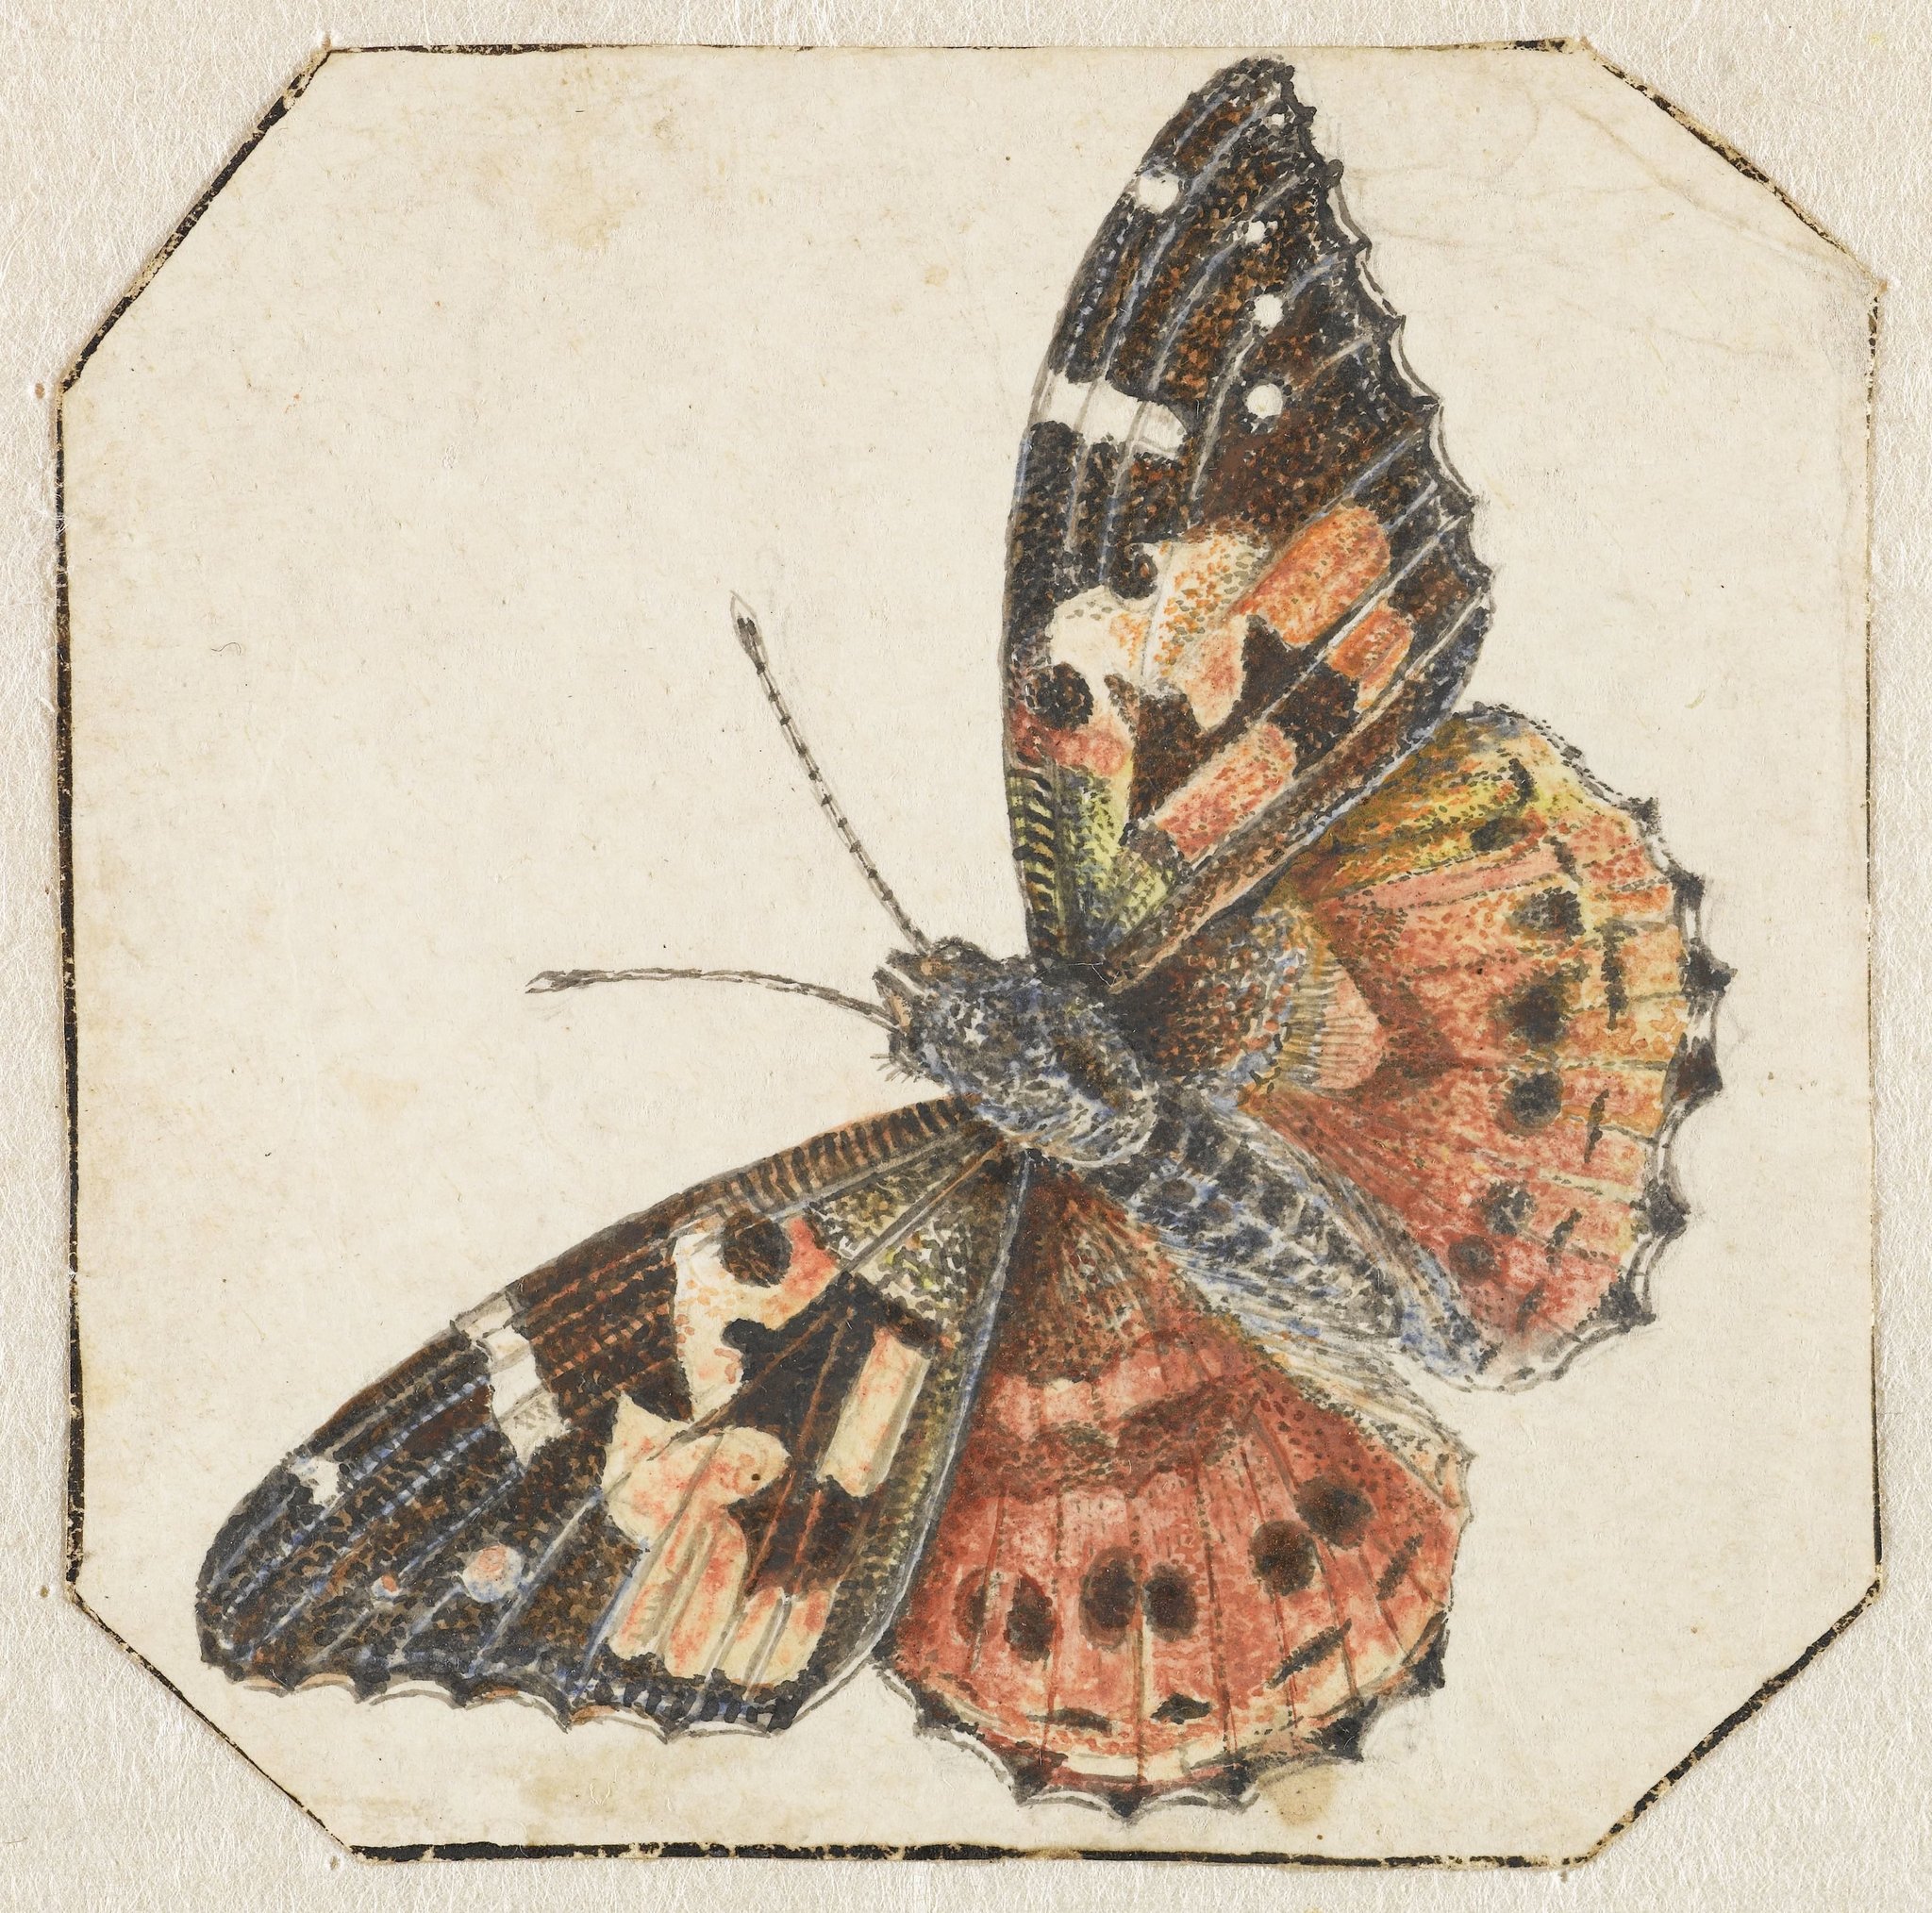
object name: watercolor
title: Distelvlinder (Vanessa cardui)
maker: pieter barbiers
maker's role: draughtsman, painter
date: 1700-1800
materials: ink, parchment, watercolor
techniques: brush, pen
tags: insects: butterfly